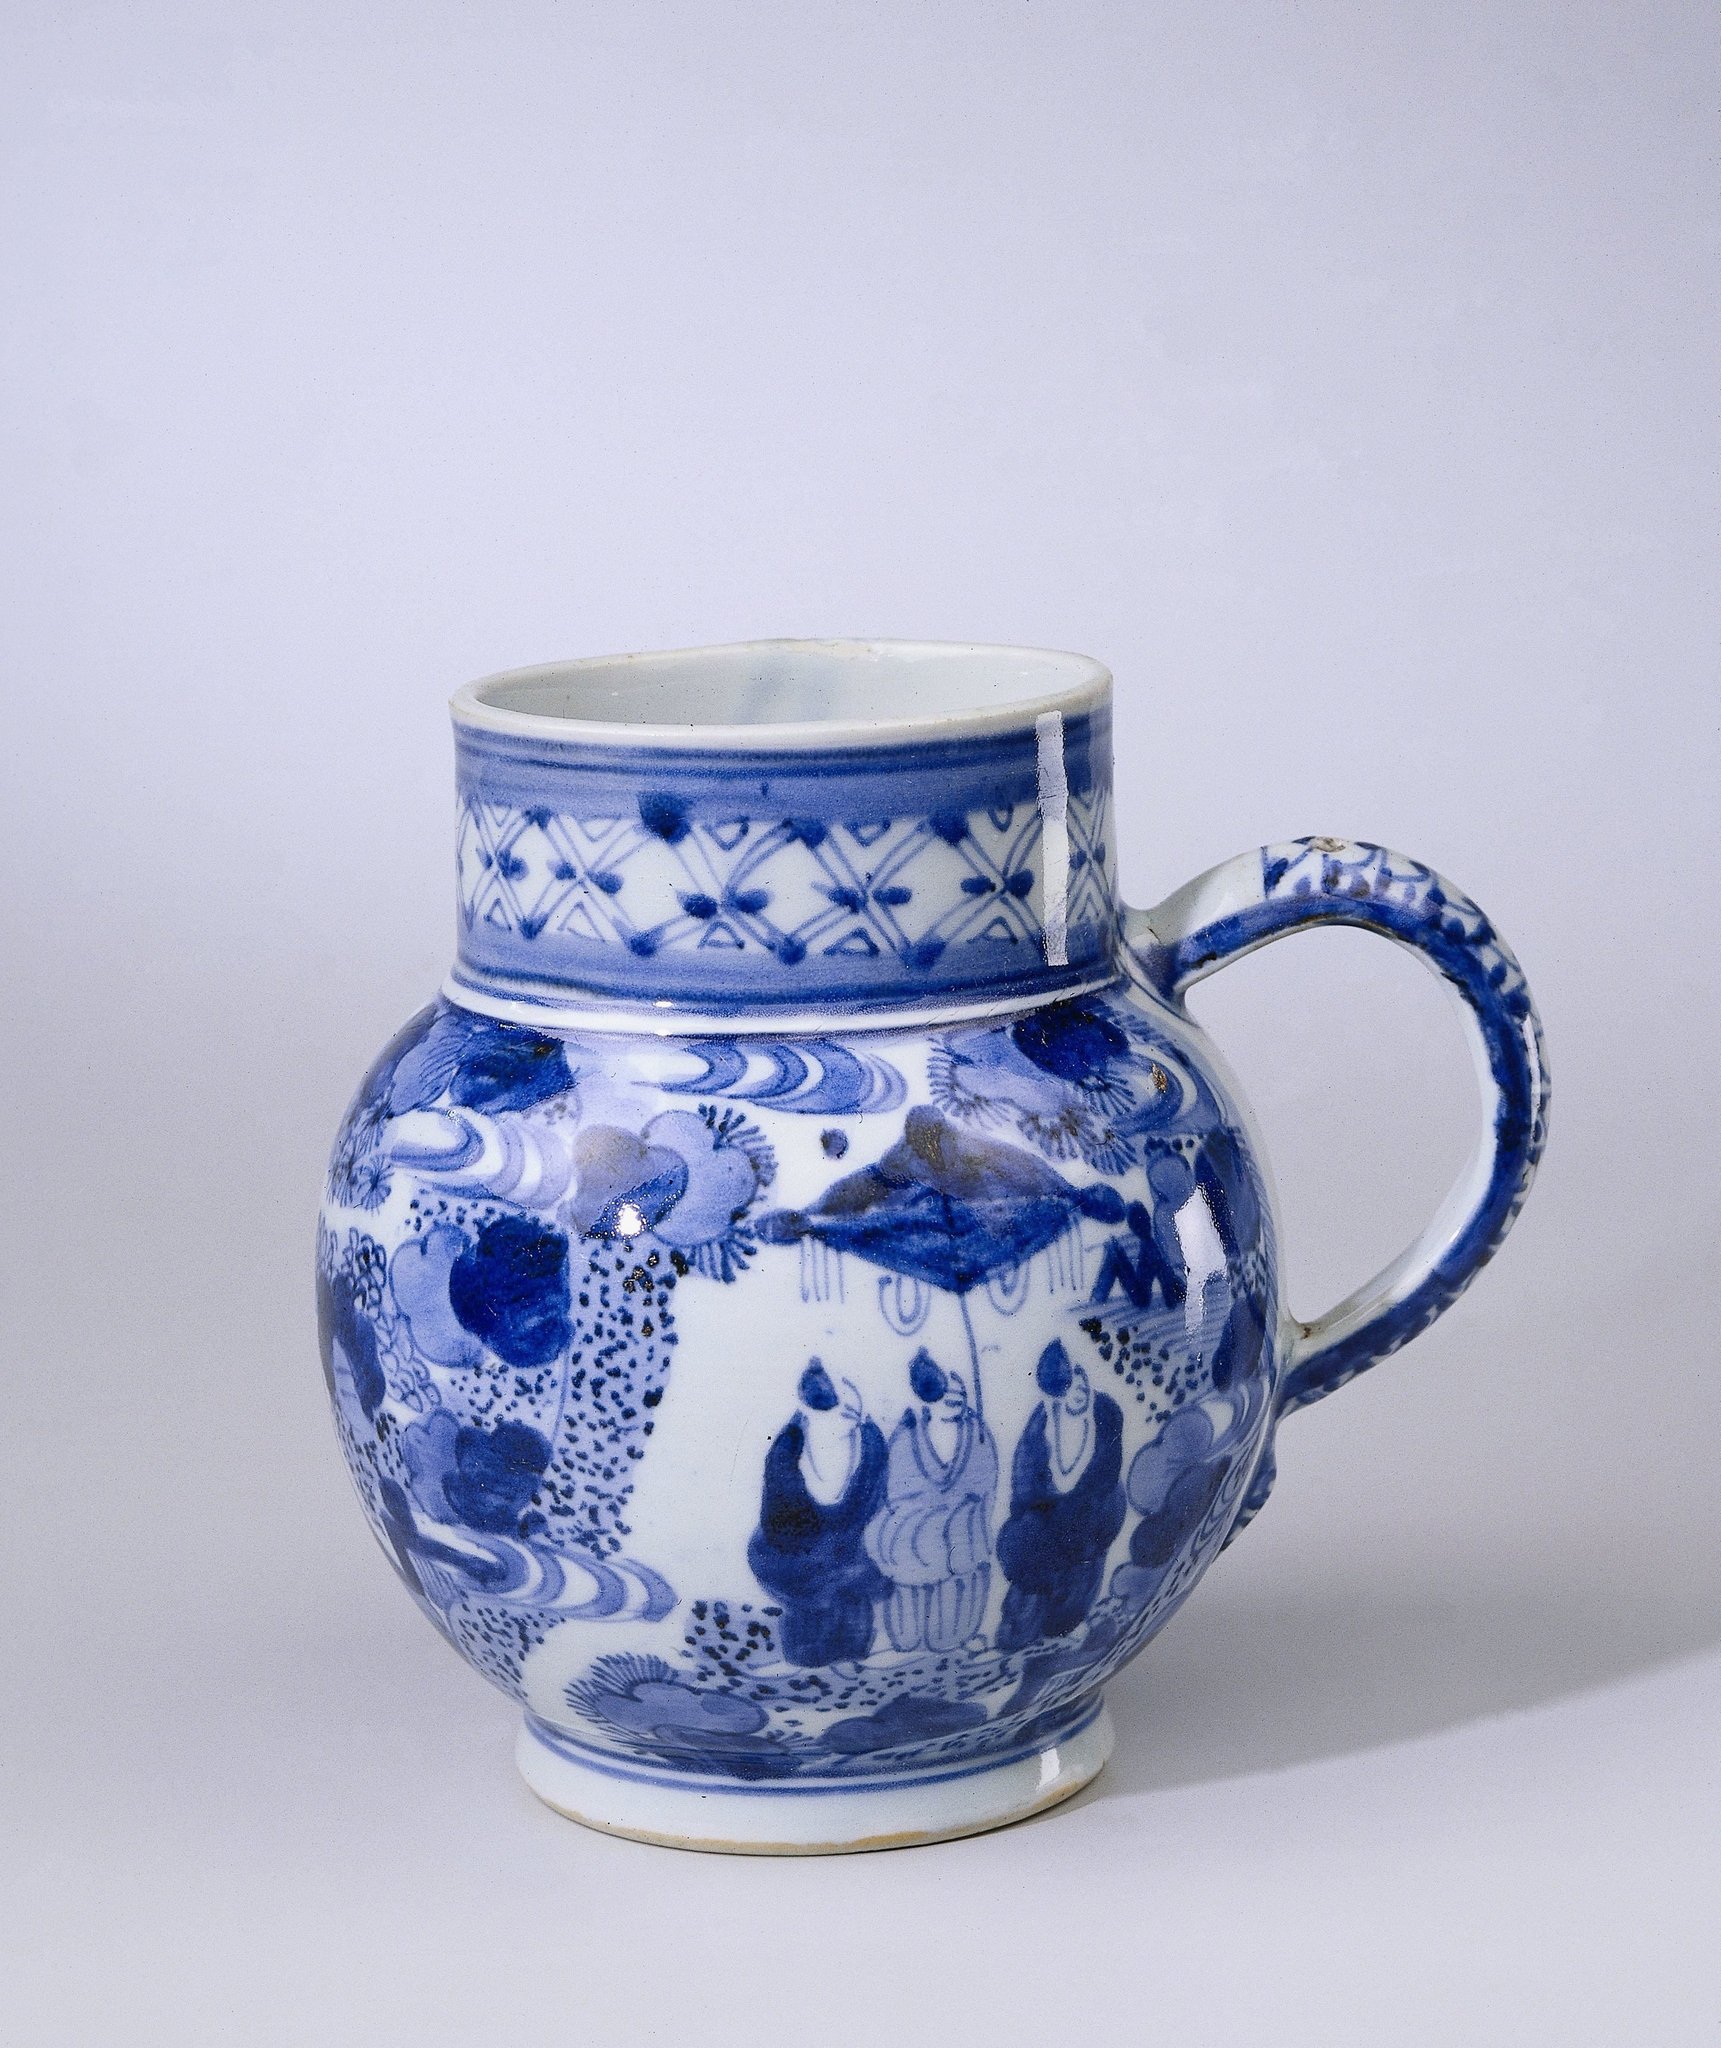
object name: stave tankard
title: Tankard with figures underneath a parasol in a landscape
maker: Anonymous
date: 1660-1680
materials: cobalt, glaze, paint, porcelain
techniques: firing, turning, vitrification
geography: japan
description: Bierpul van porselein, met een bolvormig lichaam en c-vormig oor. Op de buik een doorlopend landschap met twee paar figuren met een waaier, met daarnaast nog drie figuren onder een parasol bij bloeiende planten en rotsen. De rand met een brede band servetwerk. Op het oor een decoratief patroon; een gat bovenin het oor voor een ontbrekend montuur. De decoratie is in navolging van het Chinese overgangsporselein. Blauw-wit.